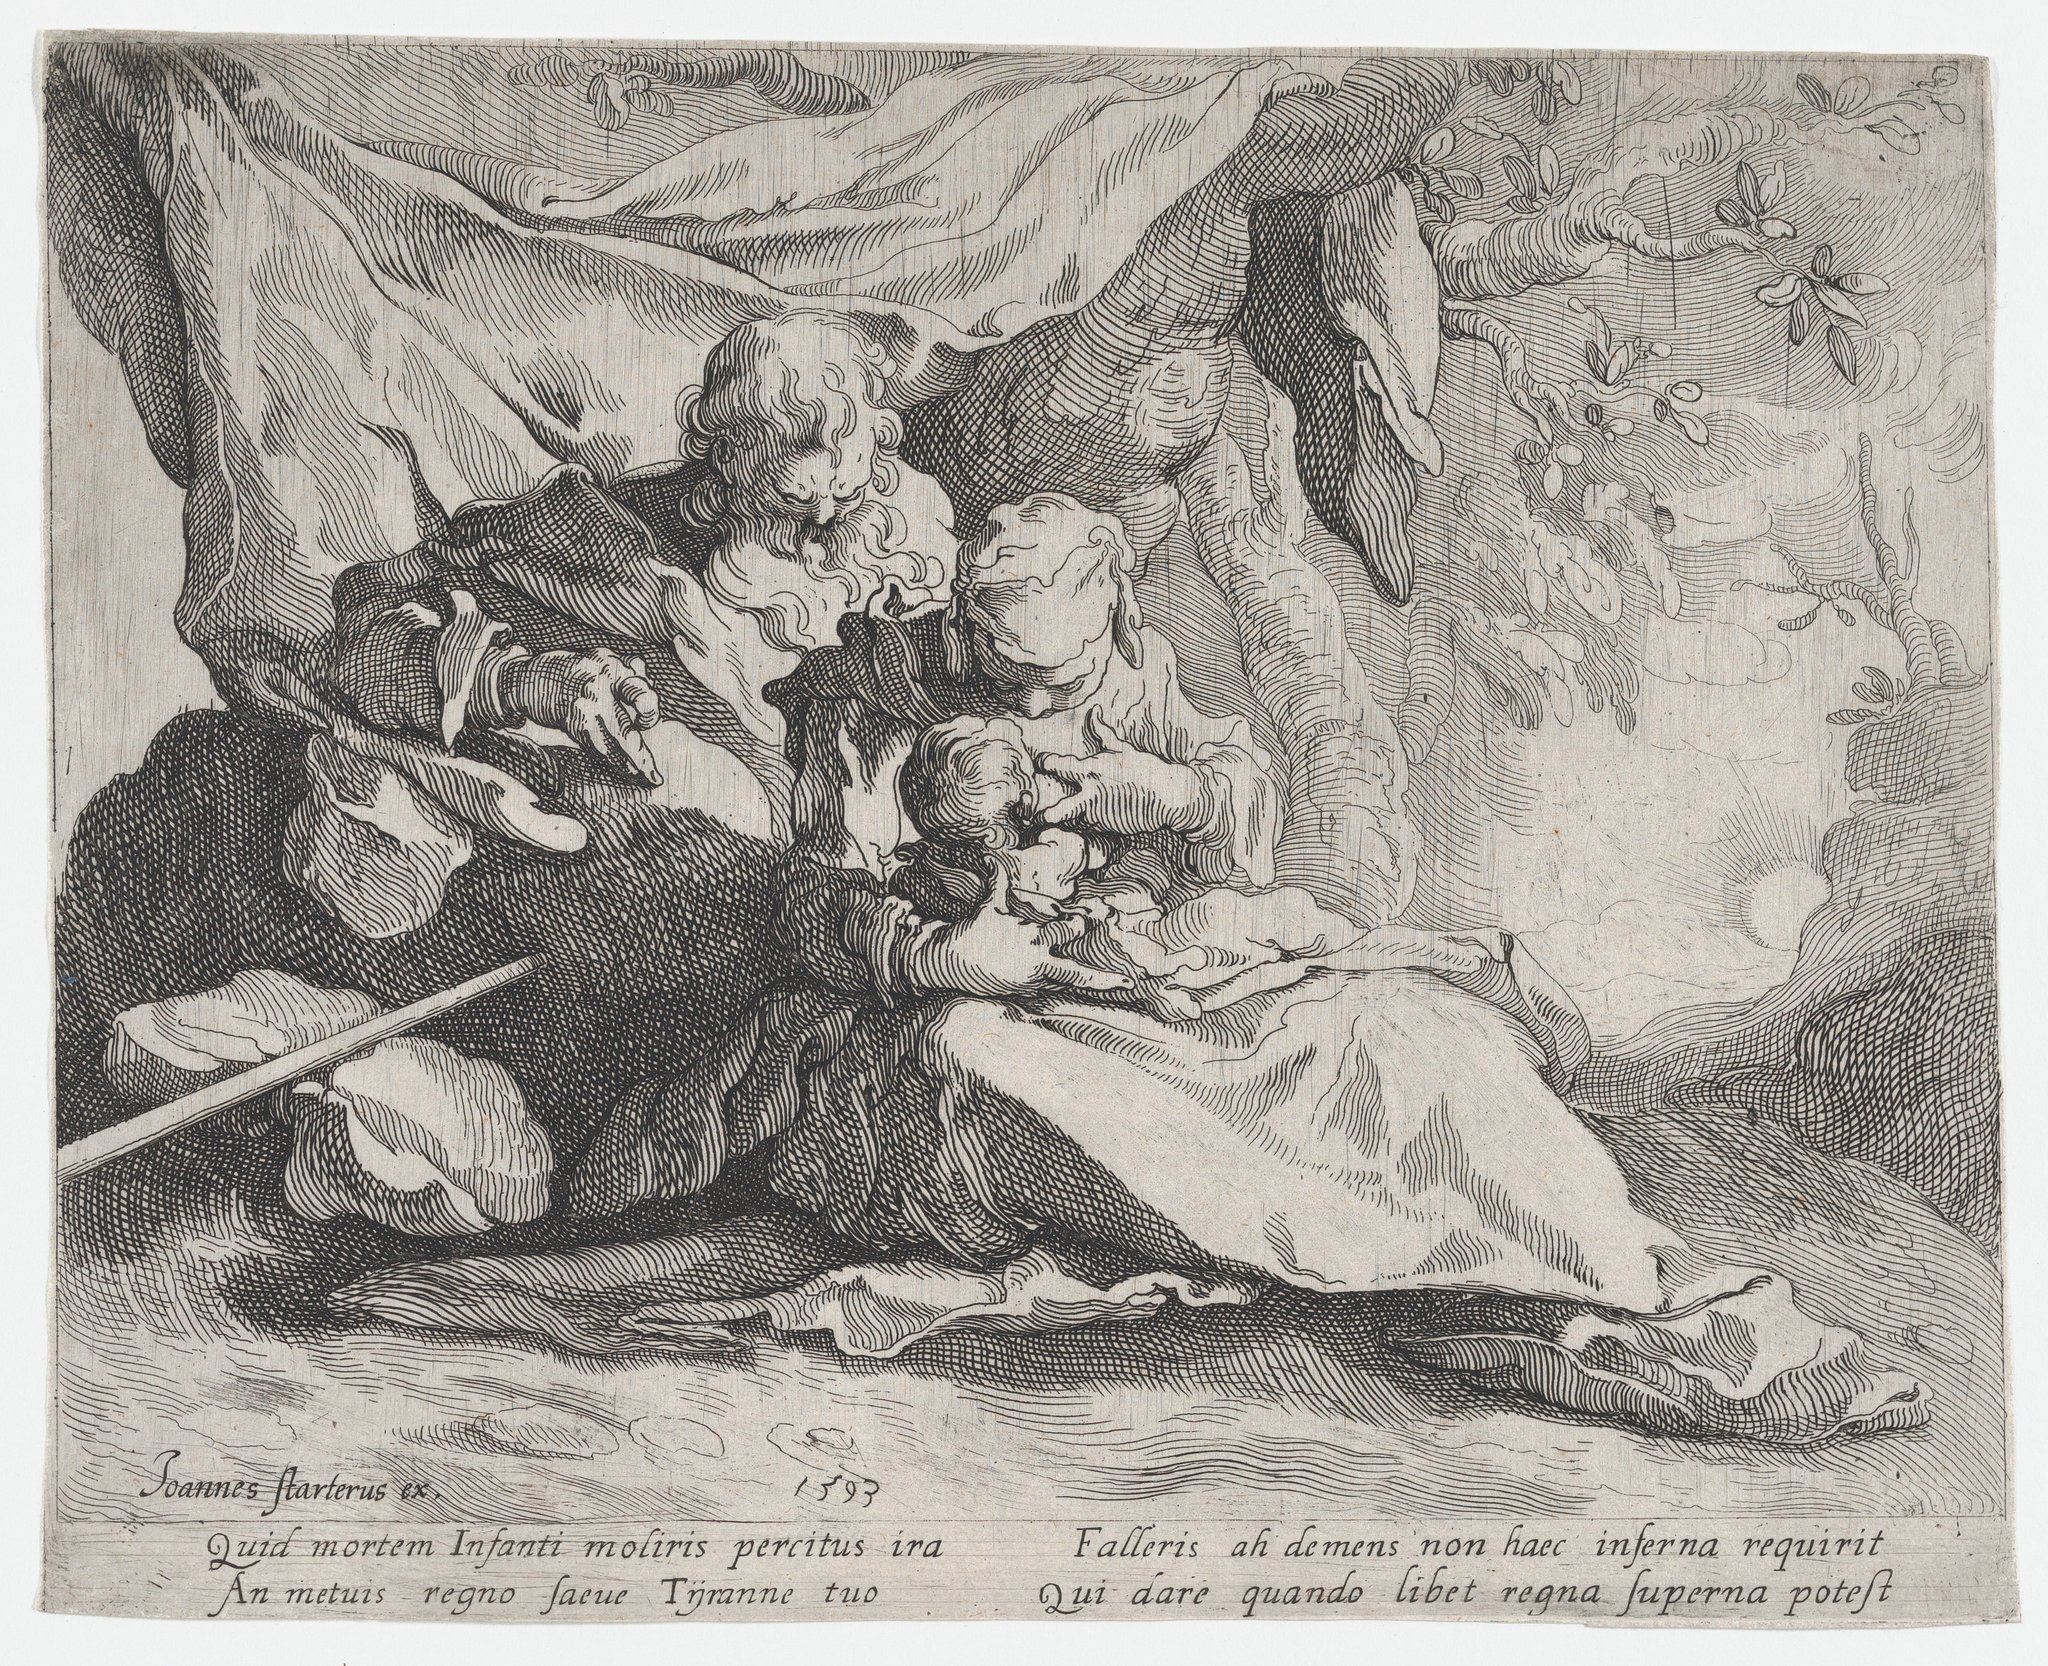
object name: print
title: The Rest on the Flight into Egypt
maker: gerrit pietersz. sweelink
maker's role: artist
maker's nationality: netherlandish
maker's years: 1566-1612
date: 1593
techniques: etching